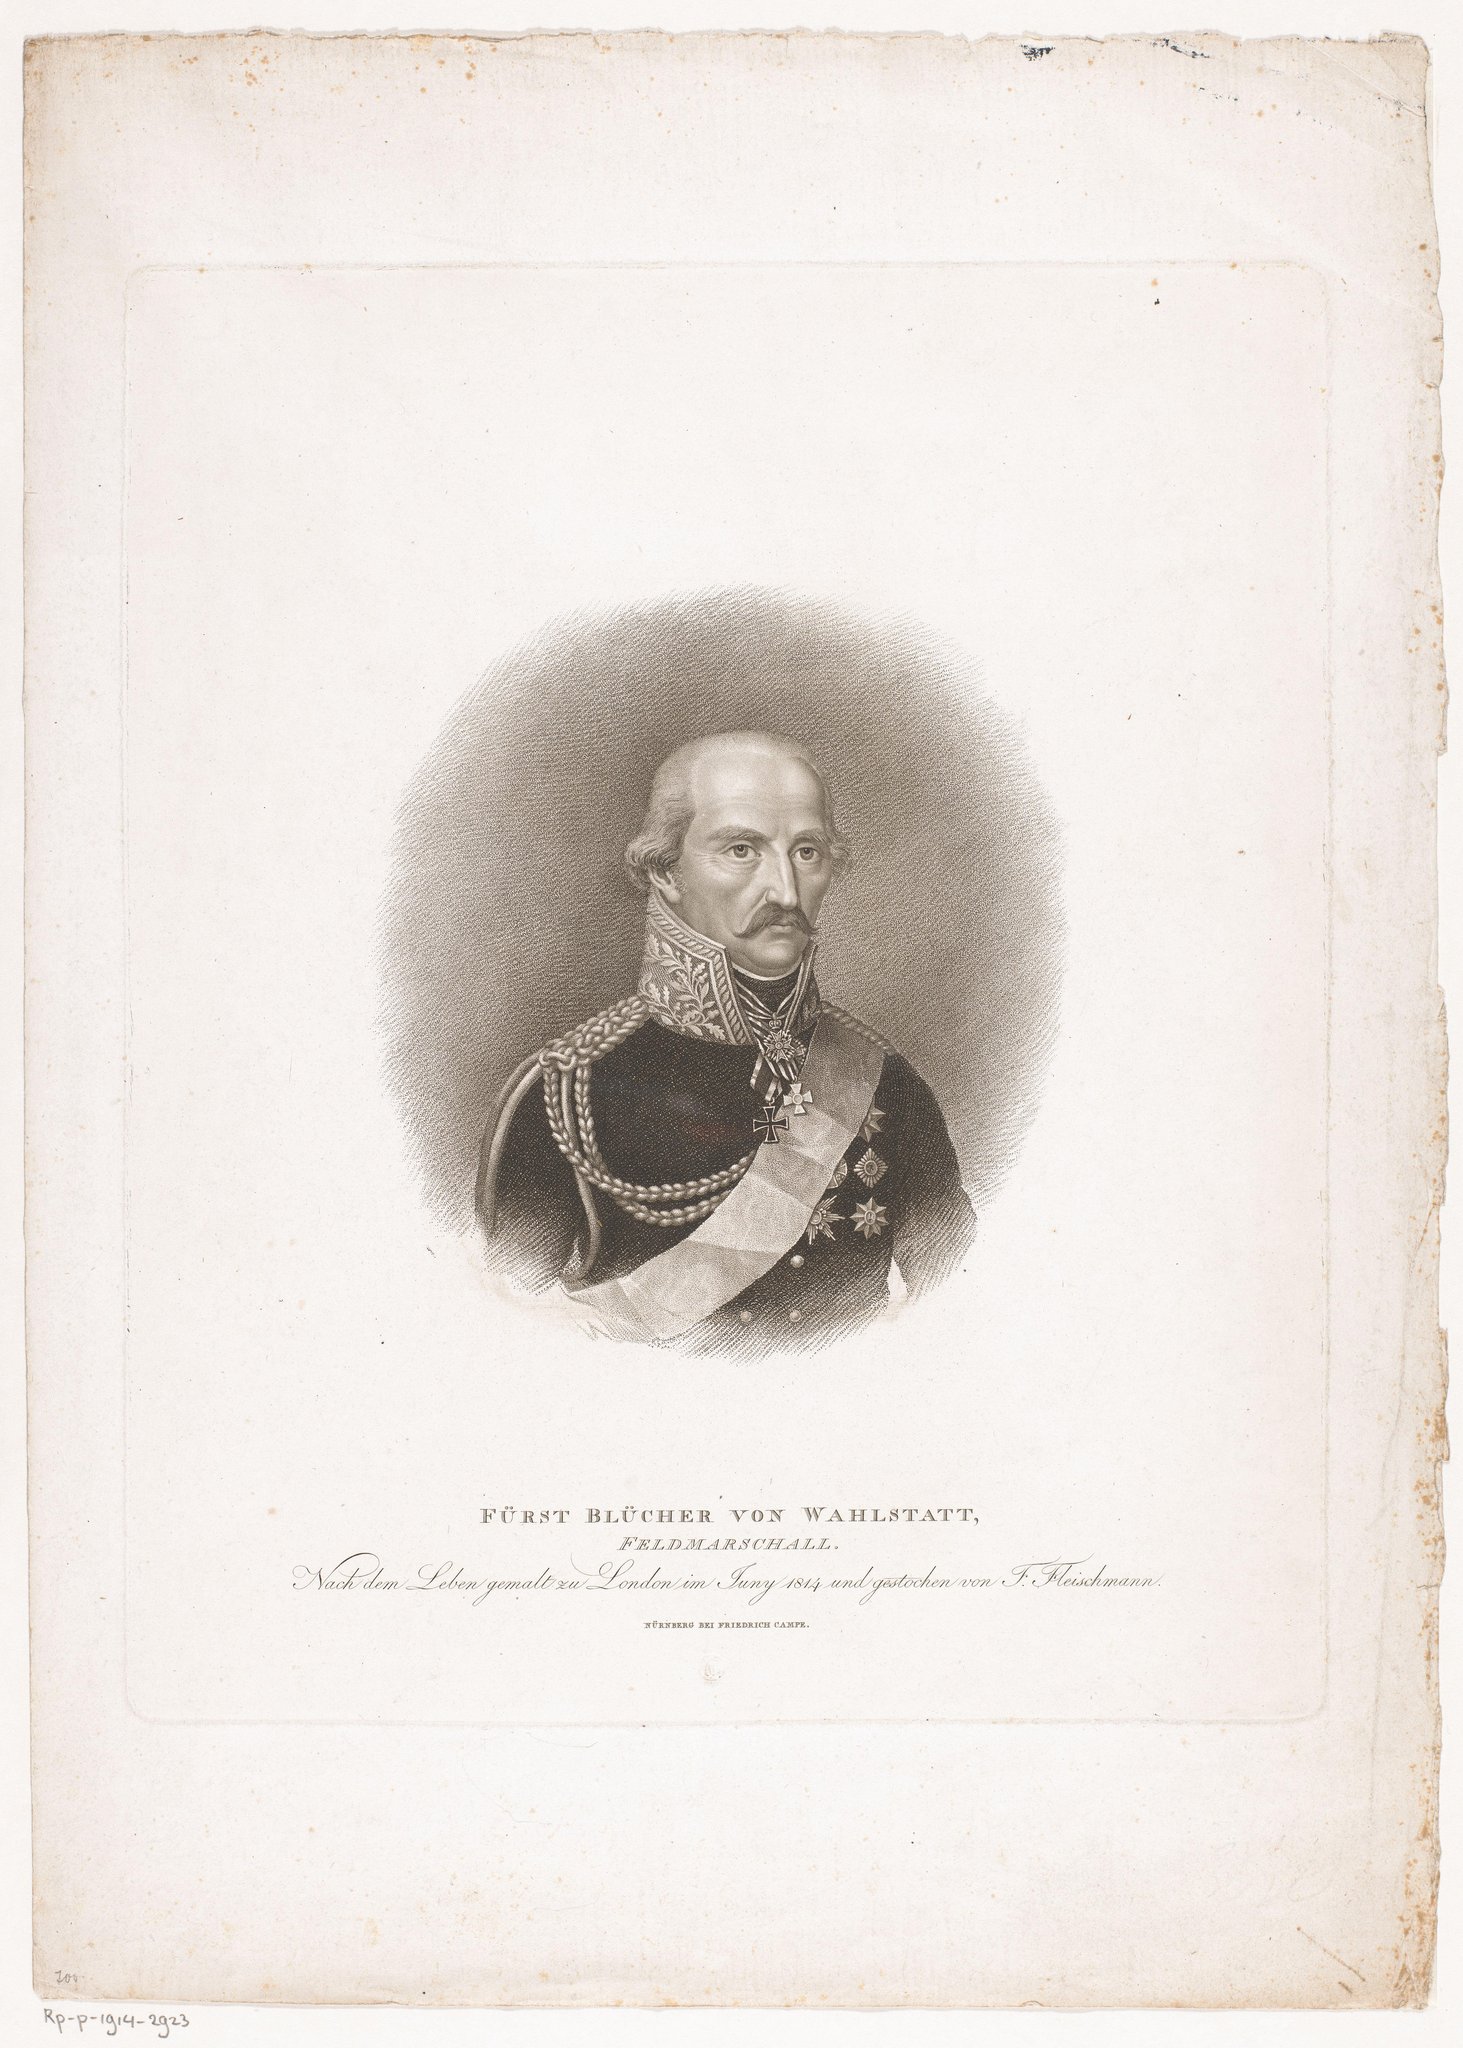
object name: print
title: Portret van Gebhard Leberecht Blücher von Wahlstatt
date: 1806-1814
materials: paper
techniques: roulette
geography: london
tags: commander-in-chief, general, marshal, historical persons, medals and other marks of military honour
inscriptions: monogram: ‘F. C., monogram van drukkerij Friedrich Campe te Neurenberg.’, collector's mark: Lugt 2228